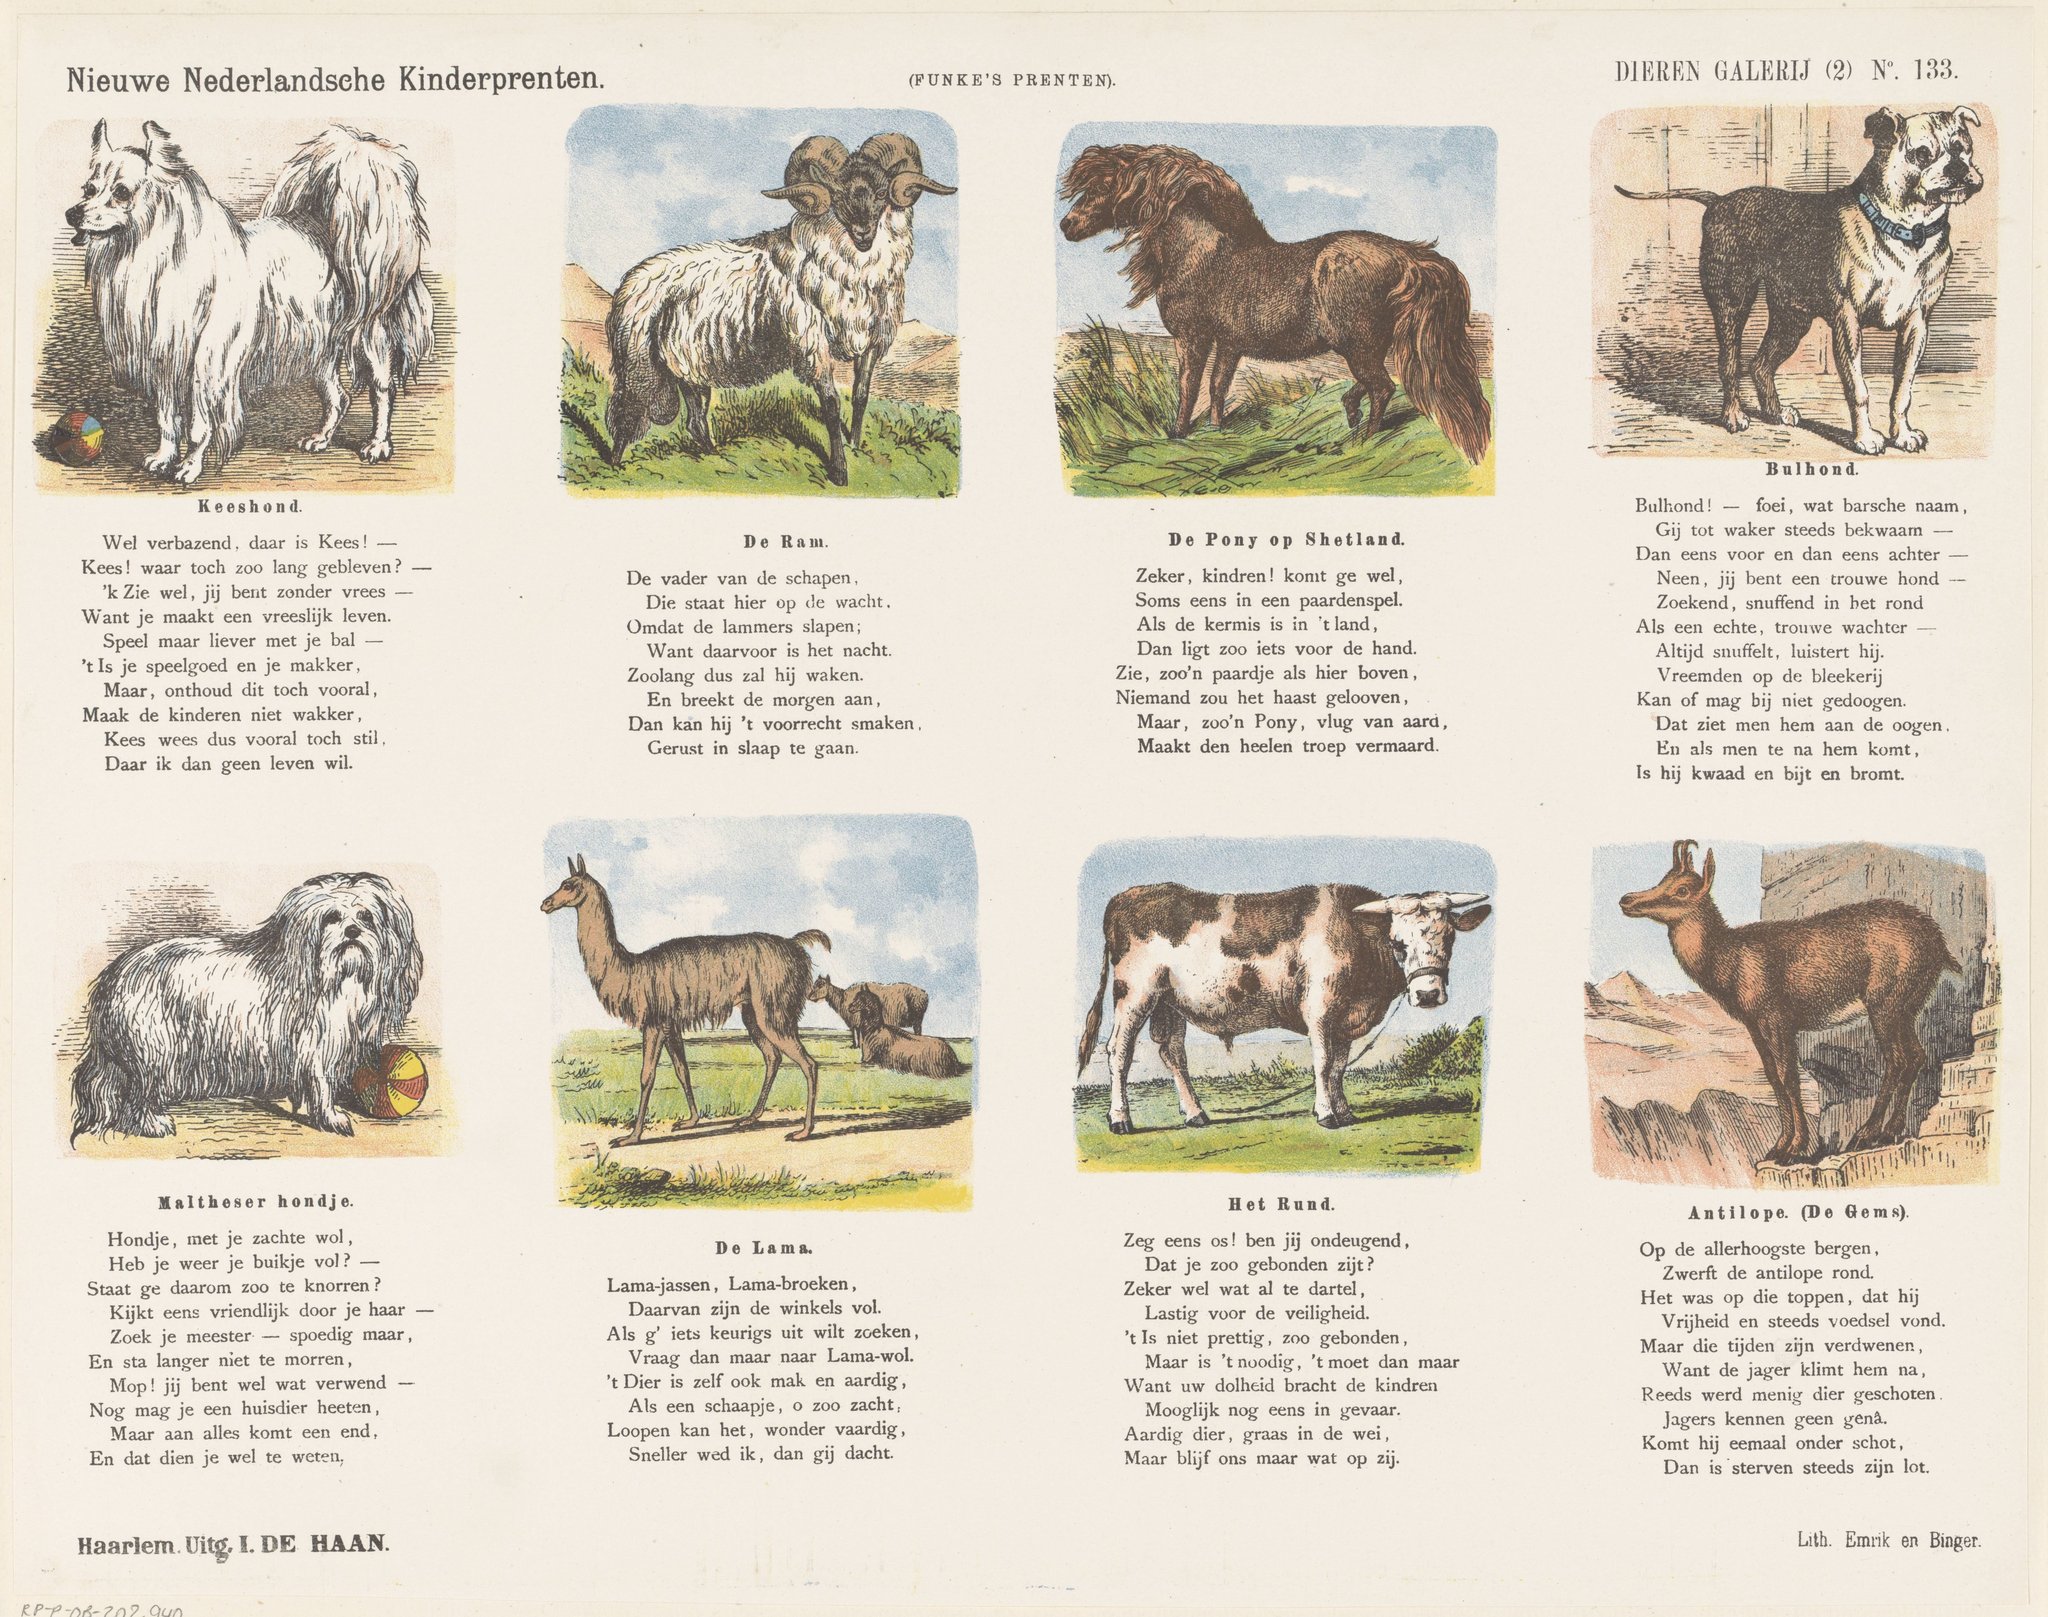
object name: popular print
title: Funke's prenten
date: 1875-1903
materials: paper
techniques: lithograph, letterpress printing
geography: haarlem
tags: cow, animals, ram, hoofed animals: antelope, dog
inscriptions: collector's mark: Lugt 2760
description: Blad met 8 voorstellingen van dieren, onder andere een keeshond, een ram, een lama en een rund. Onder elke afbeelding een vers. Genummerd rechtsboven: No. 133.